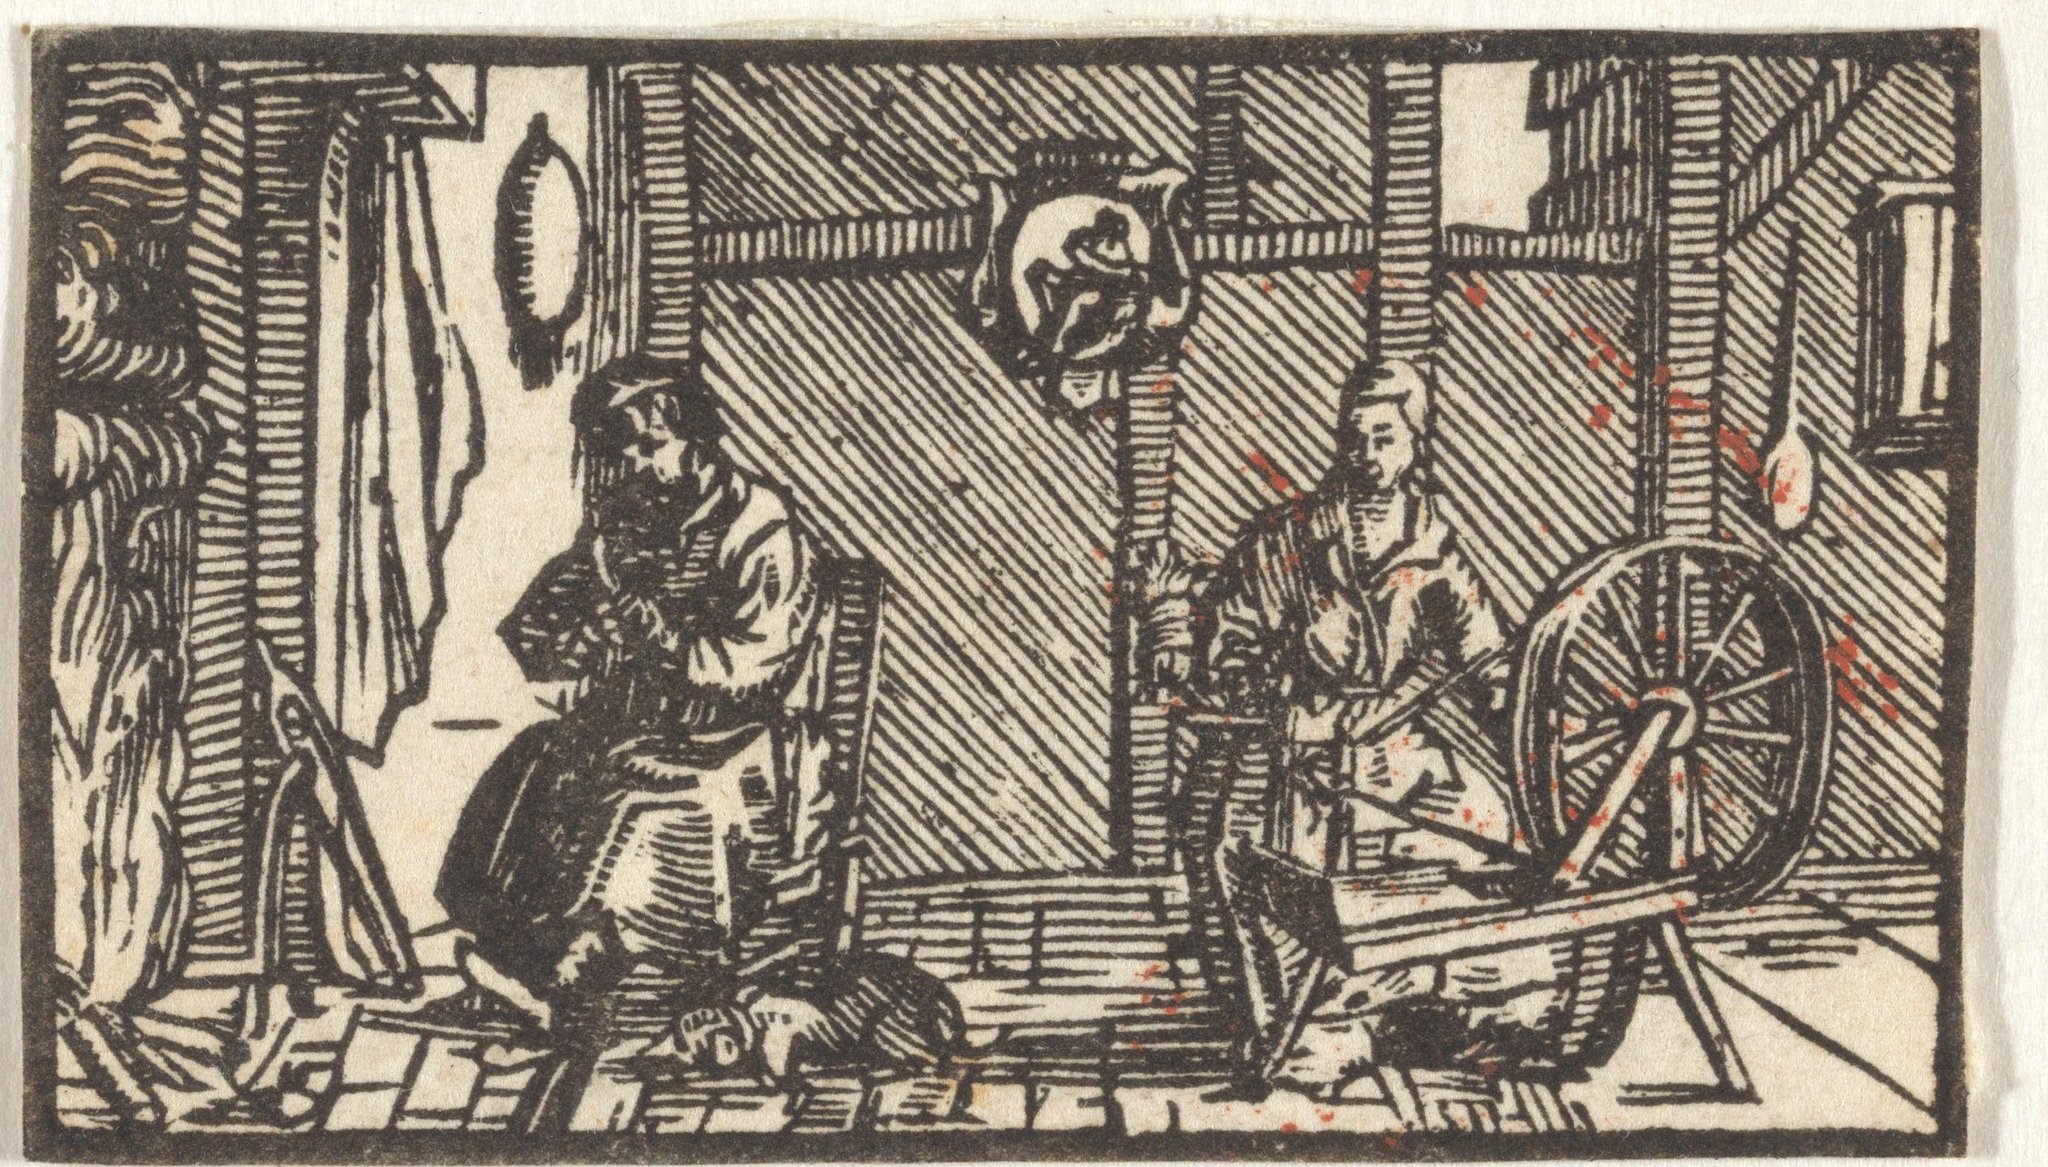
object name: print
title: Januari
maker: Anonymous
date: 1600-1699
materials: paper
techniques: woodcut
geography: netherlands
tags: january and its 'labours' (+ with aquarius (january)), open hearth, fire-place, spinning-wheel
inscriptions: collector's mark: Lugt 2228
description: Een vrouw zittend achter een spinnewiel naast een man bij een haard. Midden boven een waterman.